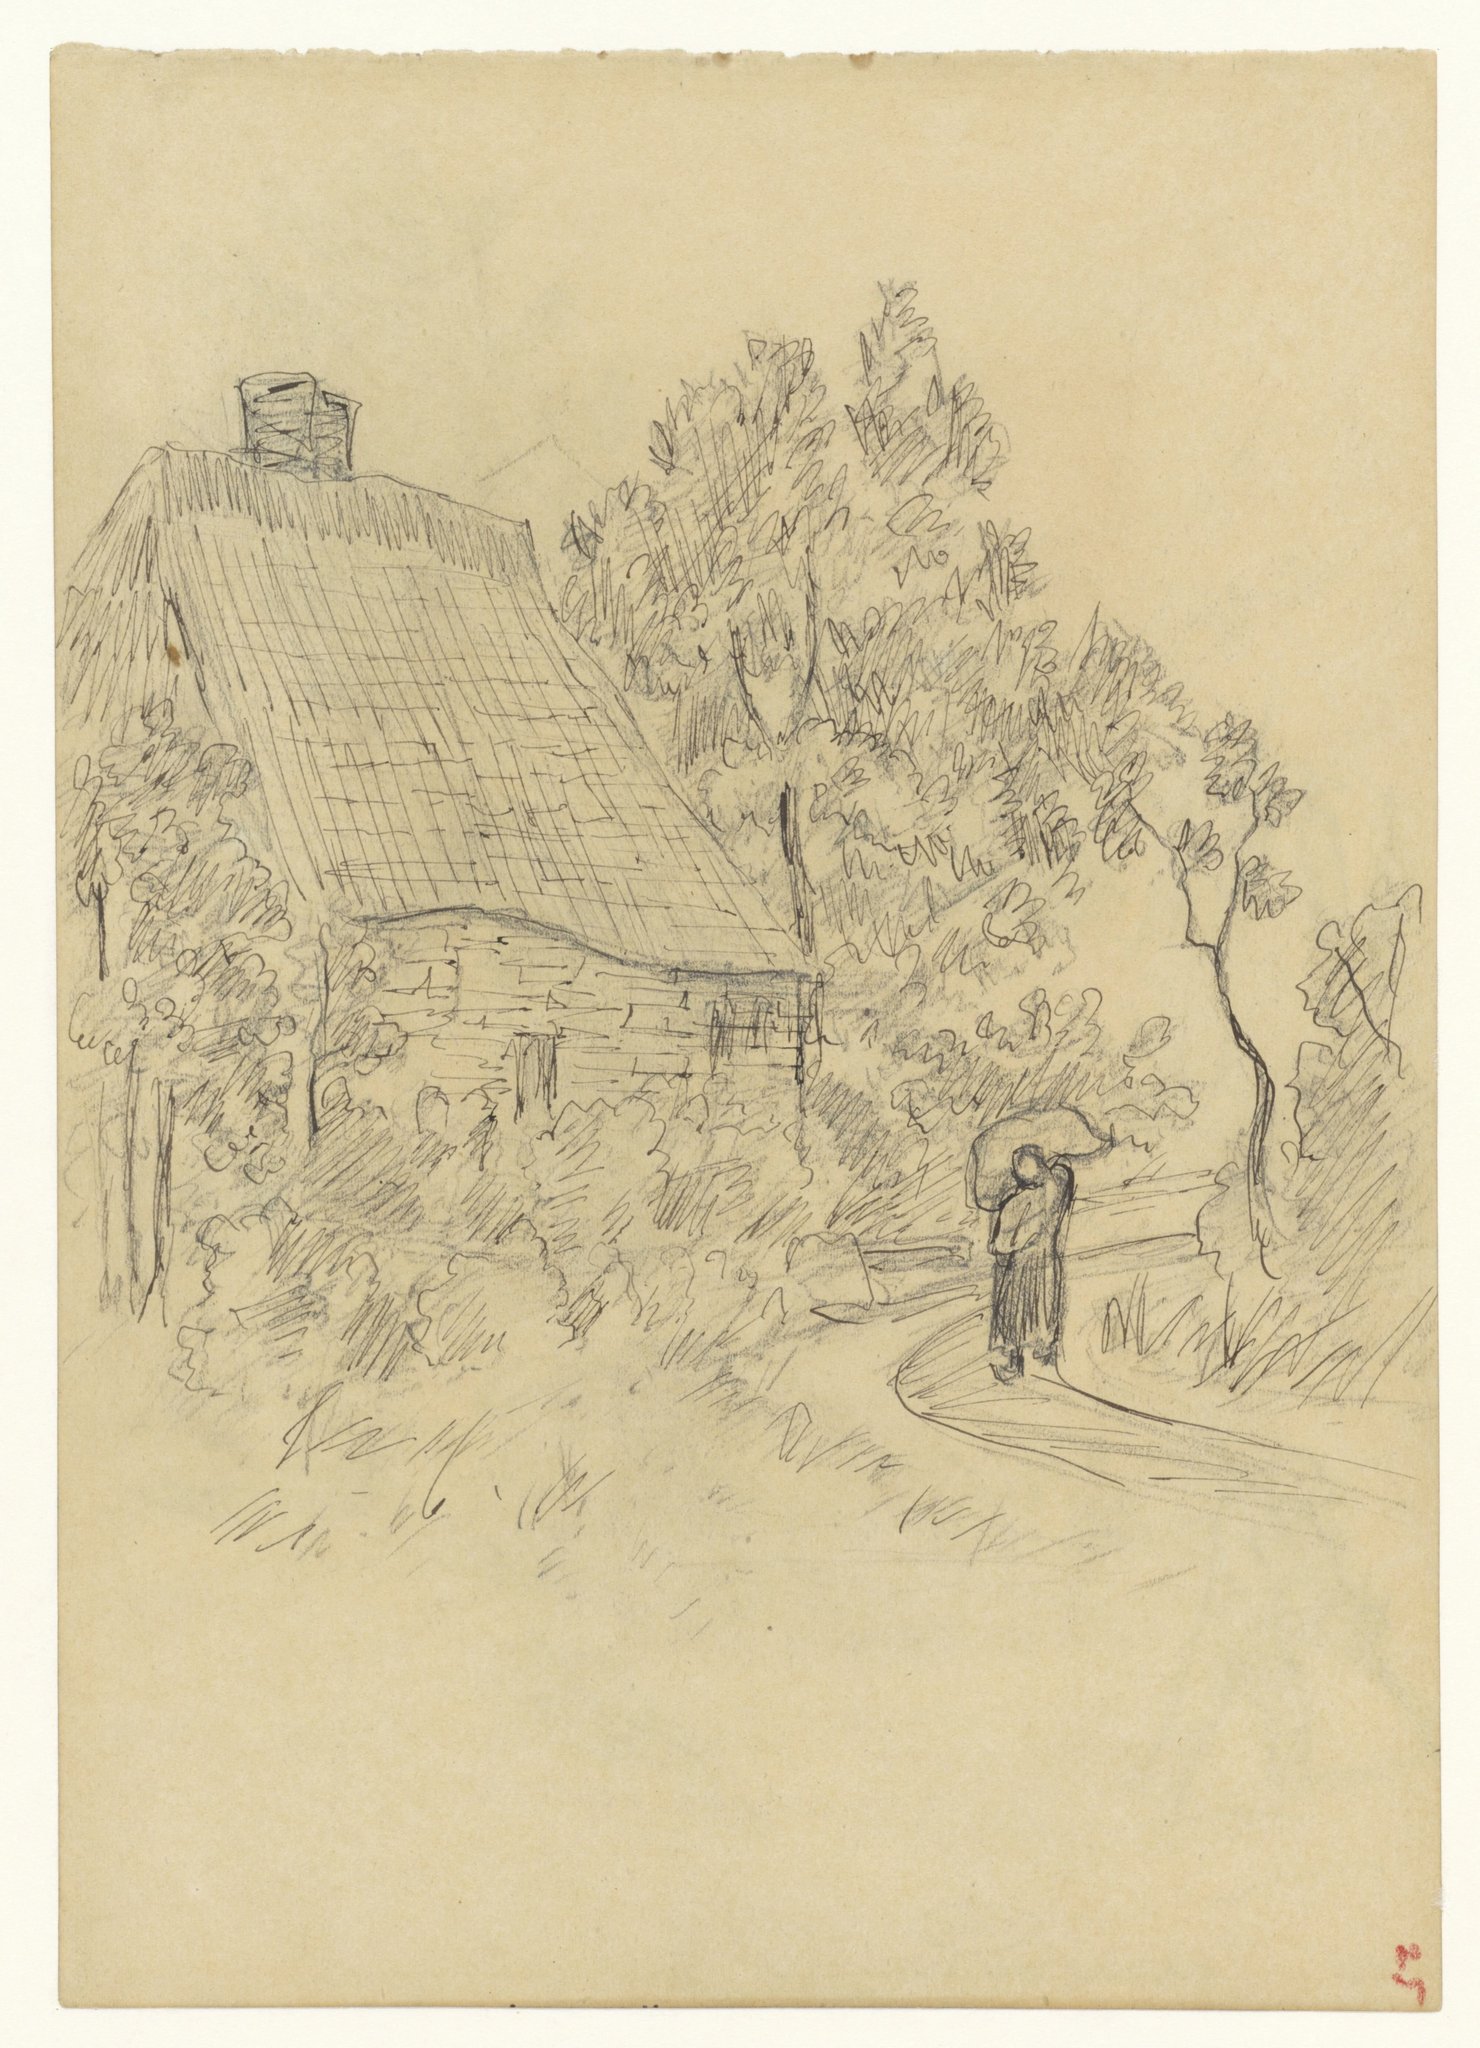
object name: drawing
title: Huis aan een landweg met een figuur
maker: jozef israëls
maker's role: draughtsman, painter, print maker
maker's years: 1824-1911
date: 1834-1911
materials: ink, paper, pencil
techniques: pen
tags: city-view, and landscape with man-made constructions